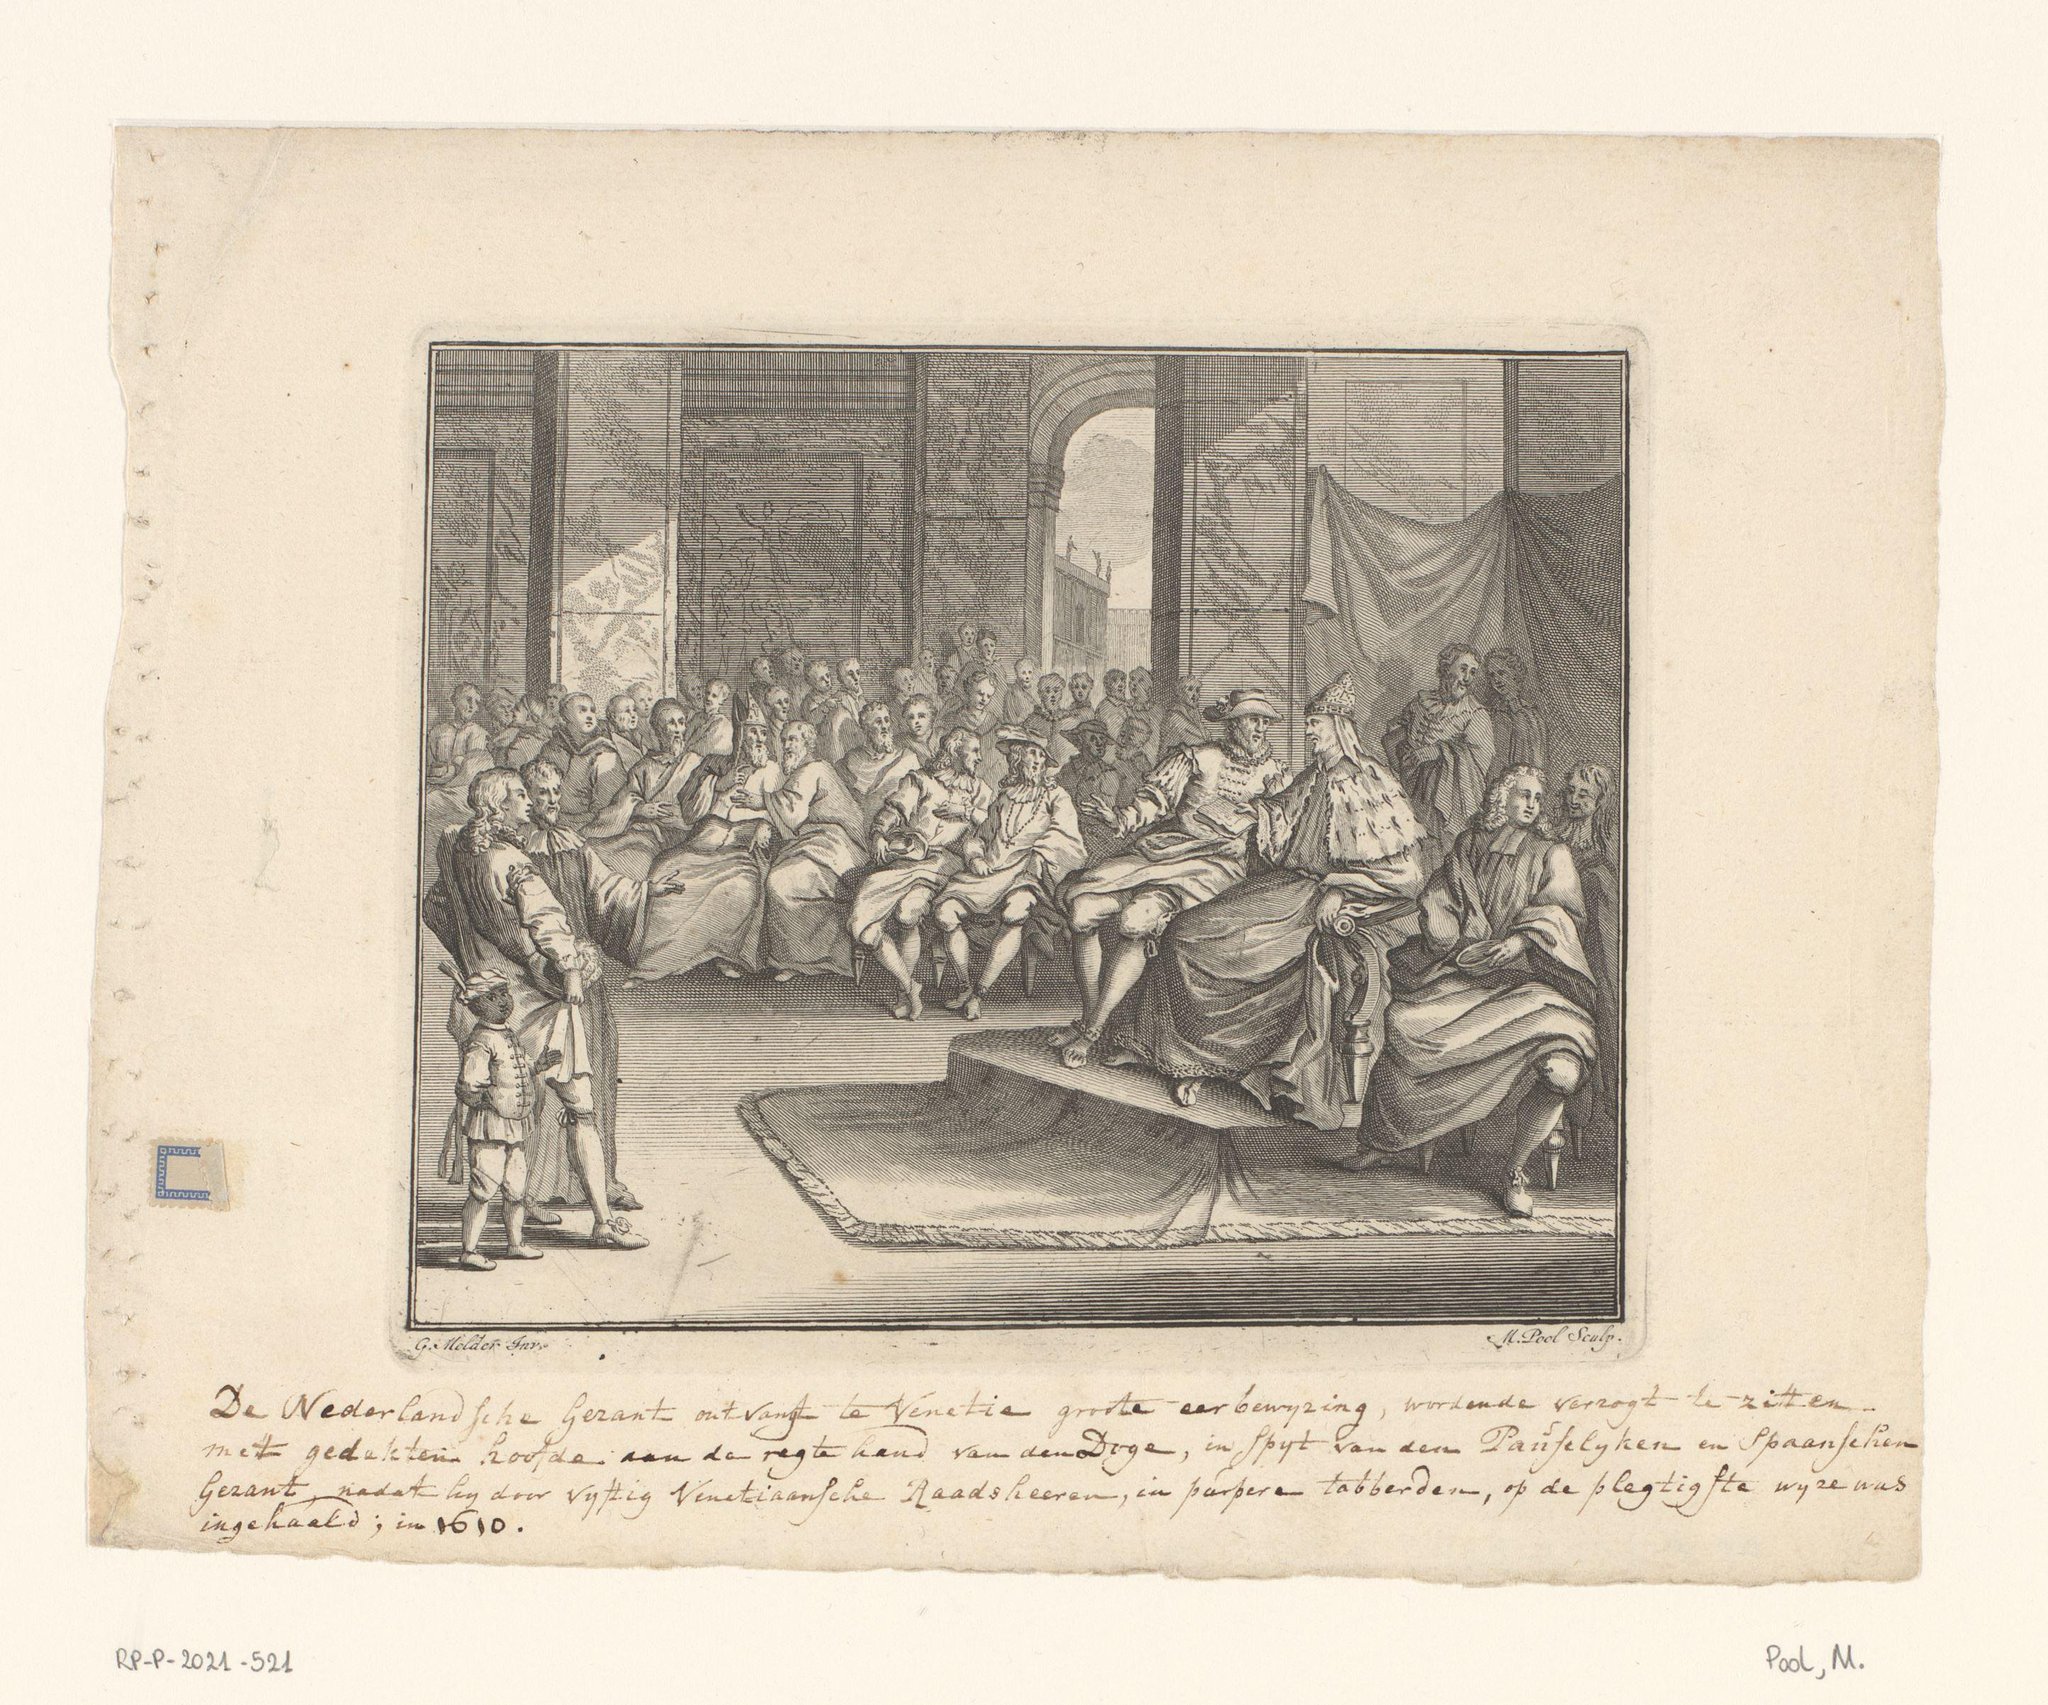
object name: print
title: Nederlandse gezant Willem van Lier te Venetië, 1627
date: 1703-1740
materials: paper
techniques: engraving, etching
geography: northern netherlands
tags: audition; ruler giving audience, venice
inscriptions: inscription: ‘De Nederlandsche Gezant ontvangt te Venetie groote eerbewijzing, wordende verzogt te zitten/ met gedekten hoofde aan de regte hand van den Doge, in spijt van den Pauselijken en Spaanschen/ Gezant, nadat hij door vijftig Venetiaansche Raadsheeren, in purpere tabberden, op de plegtigste wijze was/ ingehaald; in 1610.’, collector's mark: Lugt 2228